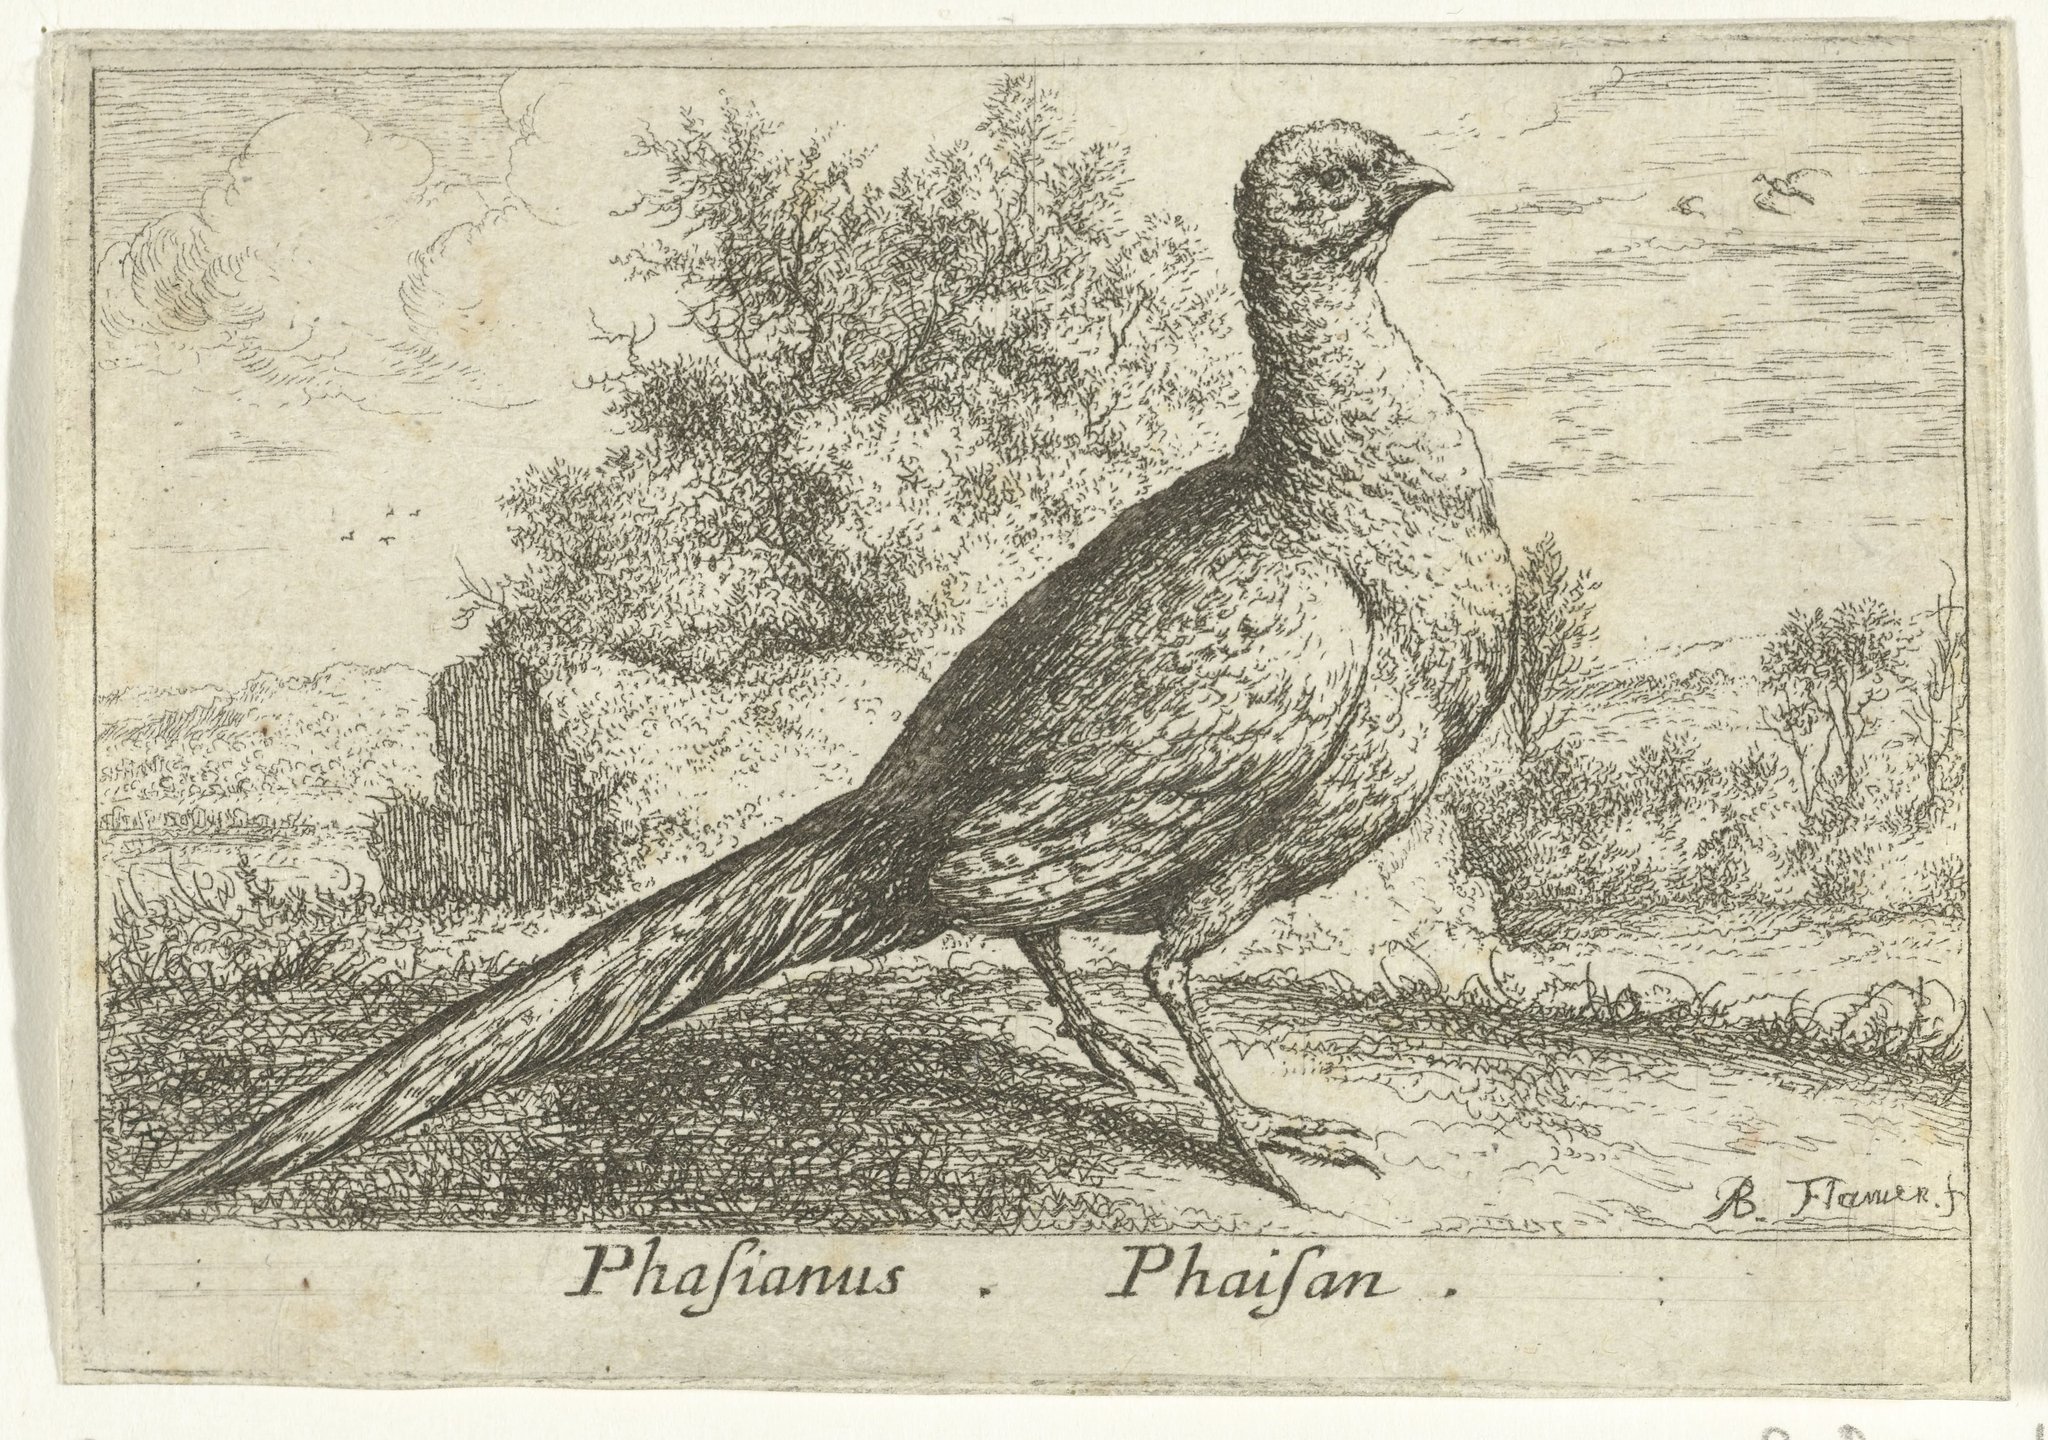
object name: print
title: Dertien vogelsoorten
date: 1659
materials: paper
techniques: etching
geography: paris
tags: walker and runner birds: pheasant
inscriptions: collector's mark: Lugt 2228